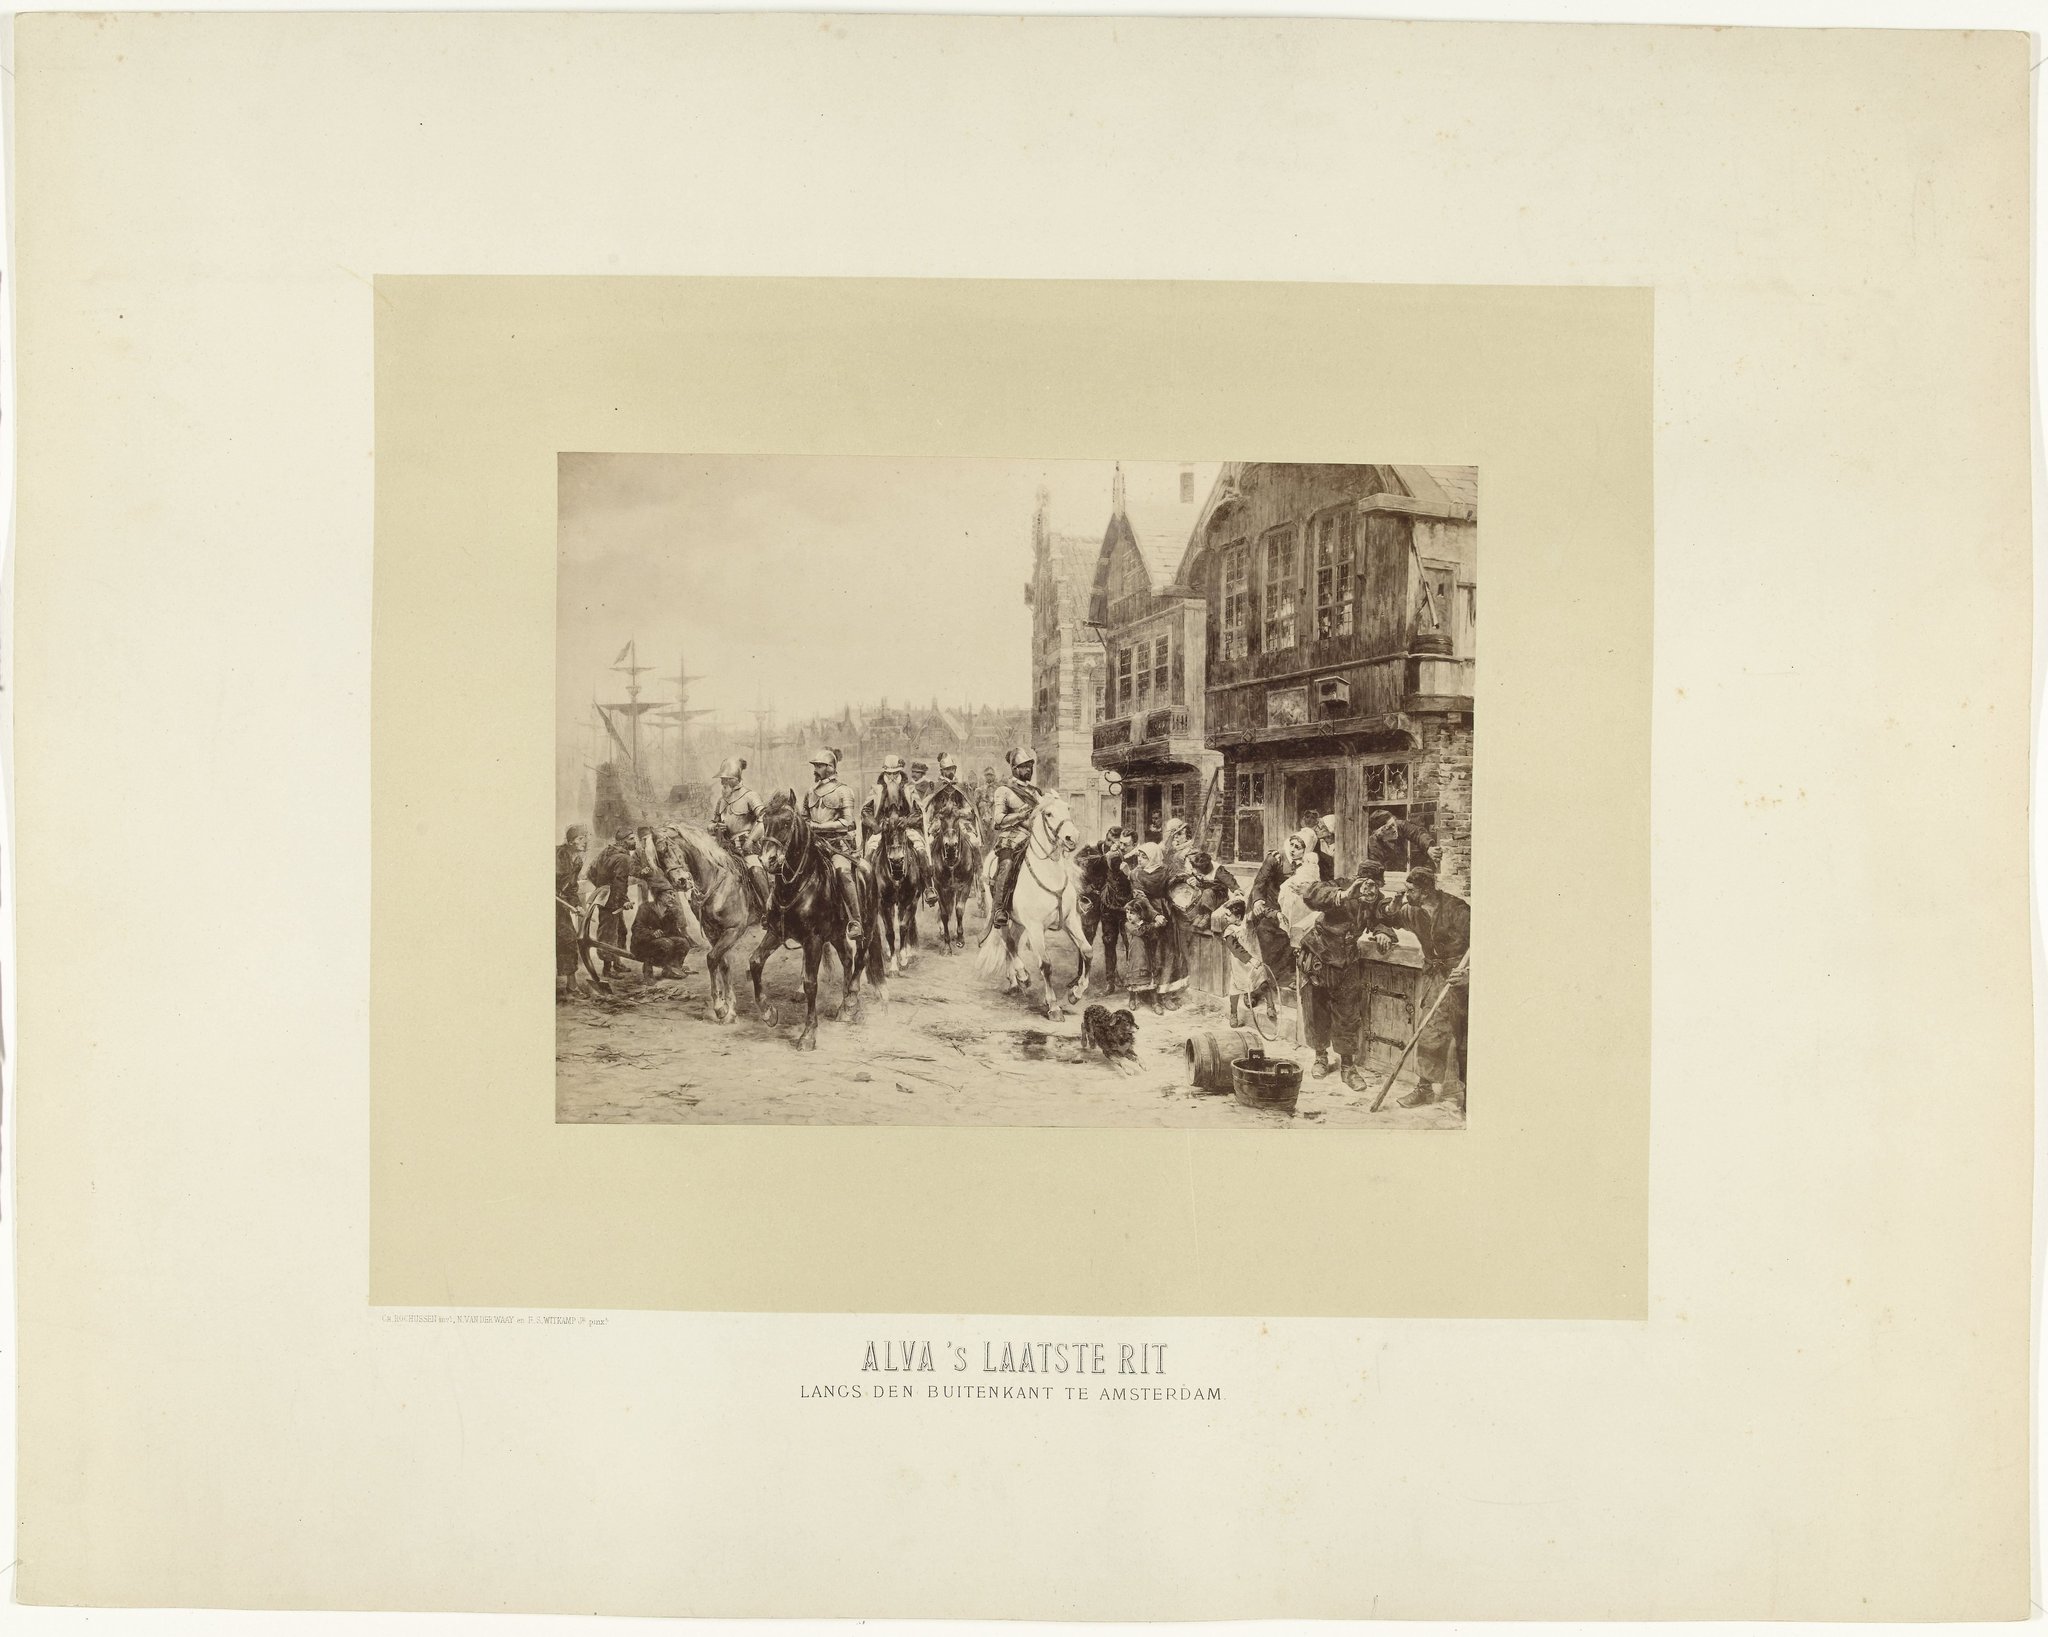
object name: photograph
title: Alva's laatste rit langs den Buitenkant te Amsterdam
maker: Anonymous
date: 1870-1890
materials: cardboard, photographic support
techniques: albumen print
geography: netherlands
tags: fernando álvarez de toledo (3rd duke of alba), military parade, pageant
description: Foto-reproductie van een schilderij van N. van der Waay en E.S. Witkamp Jr.